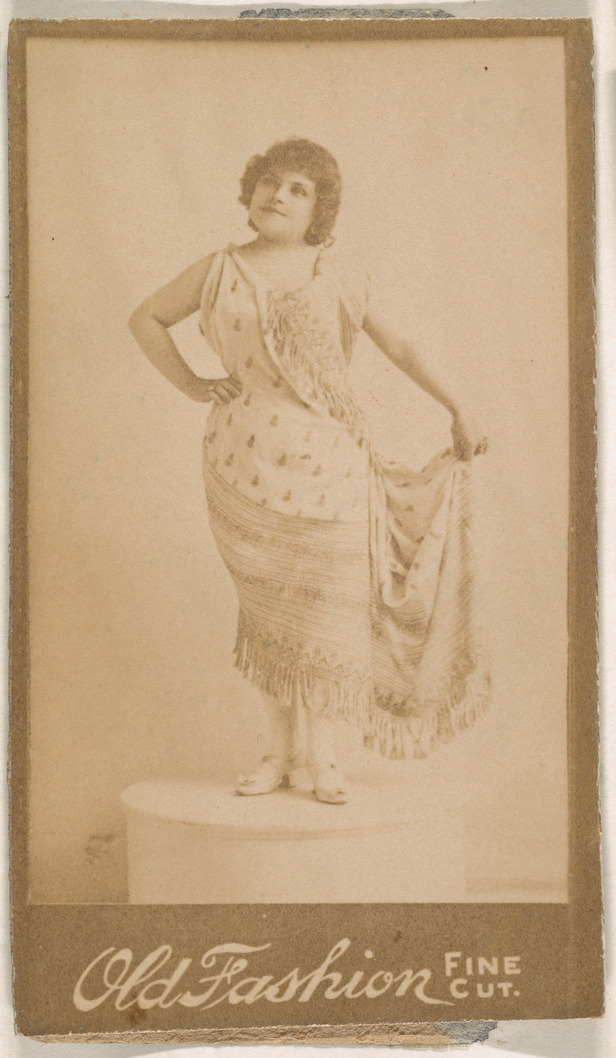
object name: photograph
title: Actress standing on pedestal, from the Actresses series (N664) promoting Old Fashion Fine Cut Tobacco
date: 1888-1890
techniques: albumen silver print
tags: portraits,women,actresses